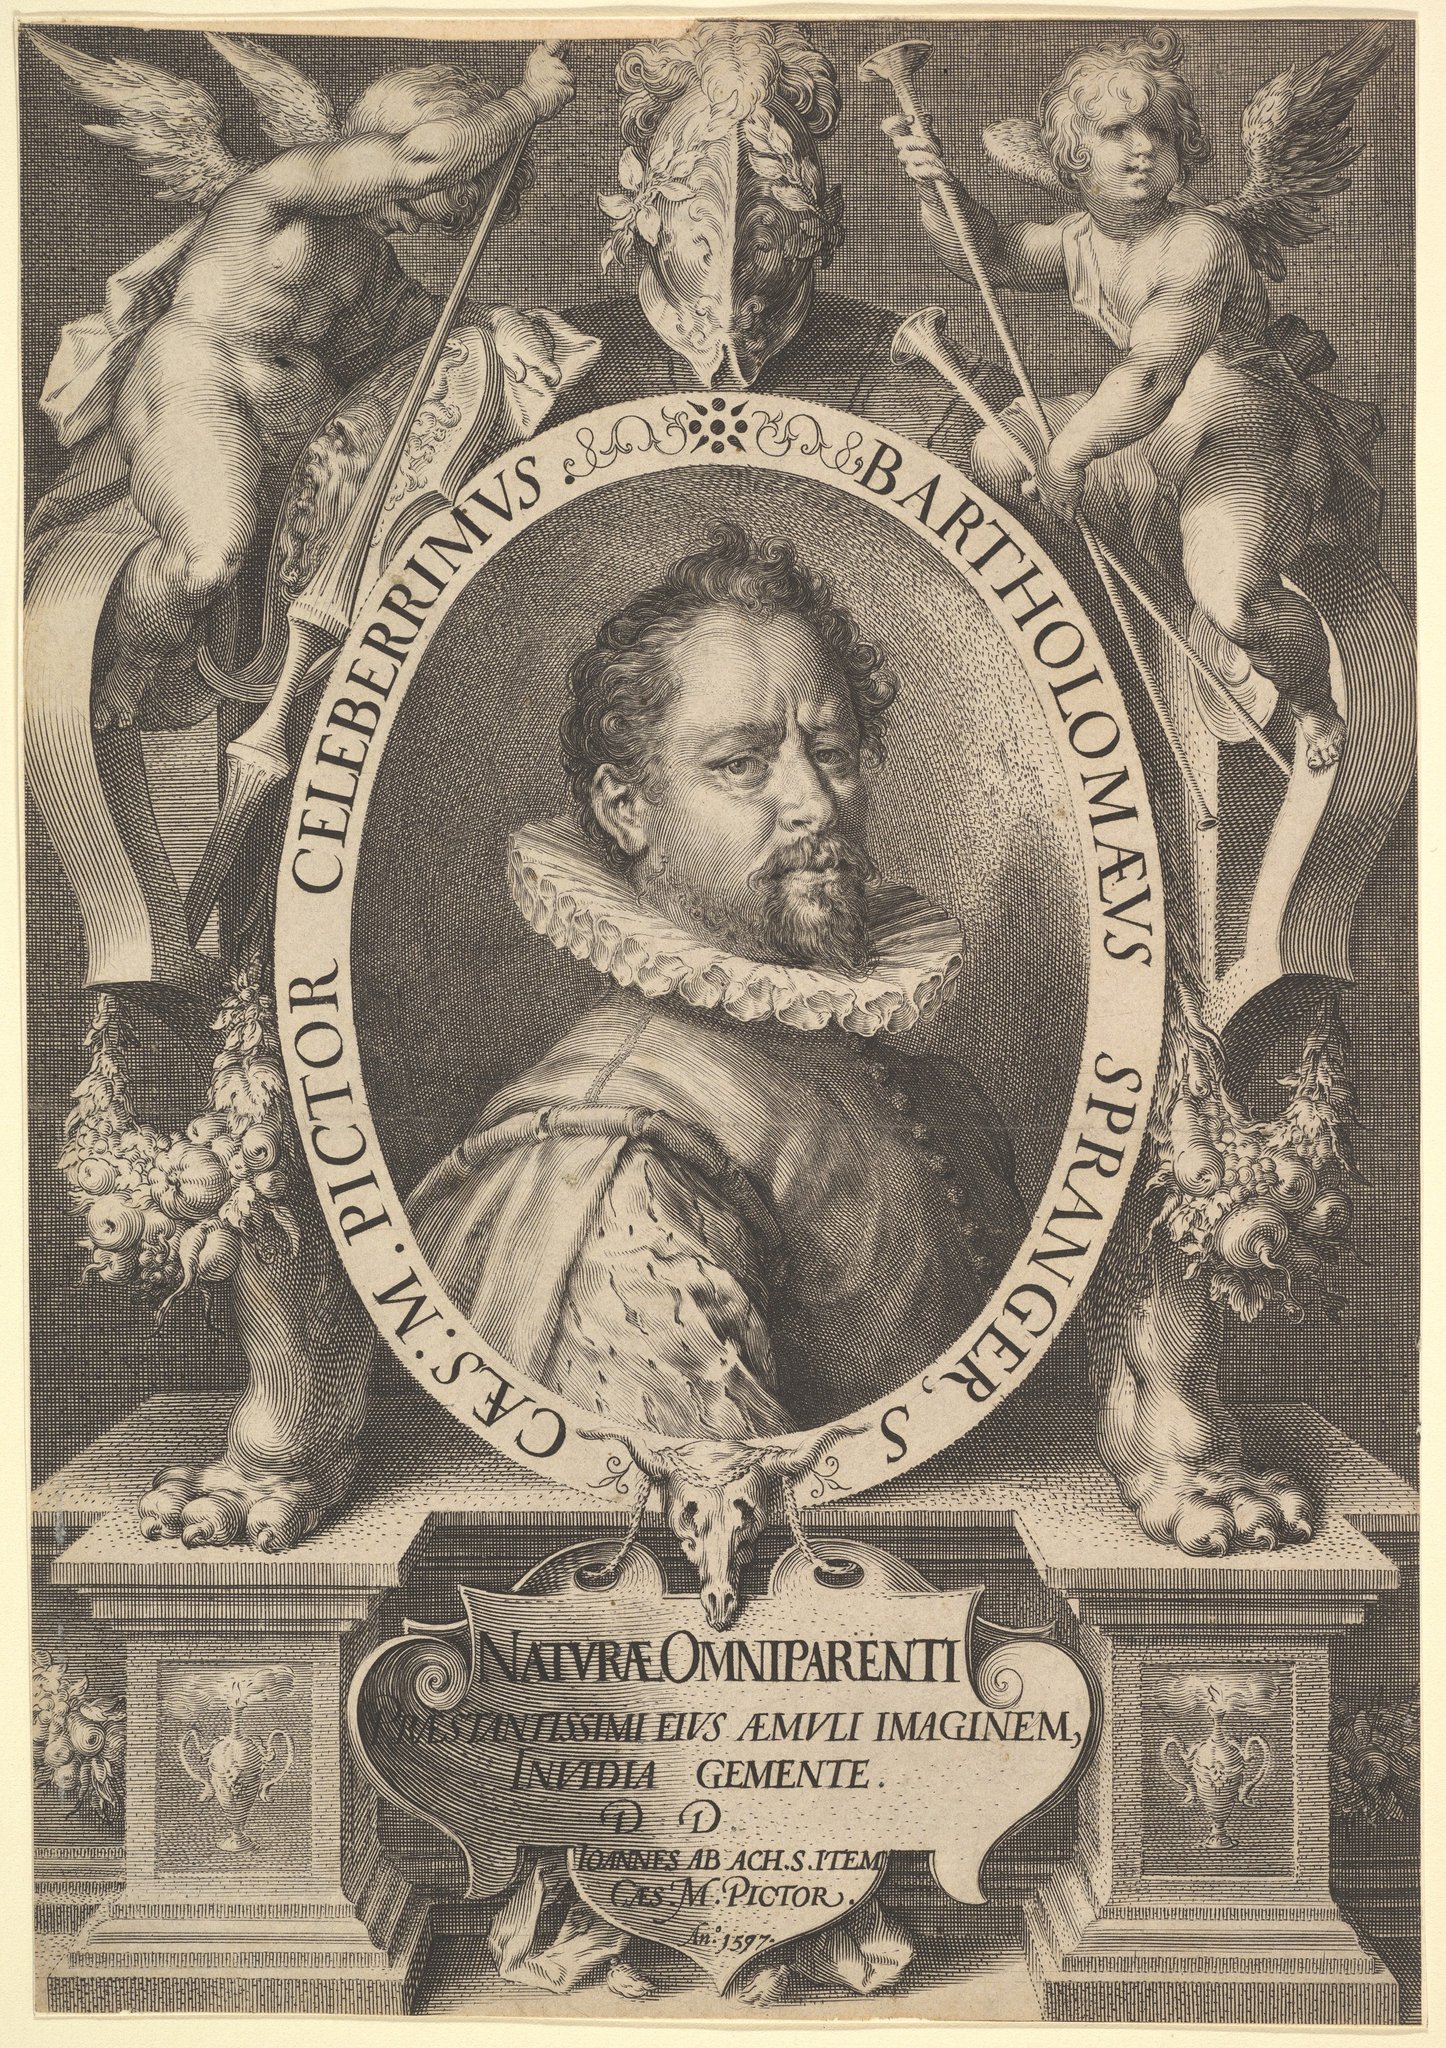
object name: print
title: Portrait of Bartholomeus Spranger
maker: jan muller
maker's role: artist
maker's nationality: netherlandish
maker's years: 1571-1628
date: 1597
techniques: engraving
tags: men,portraits